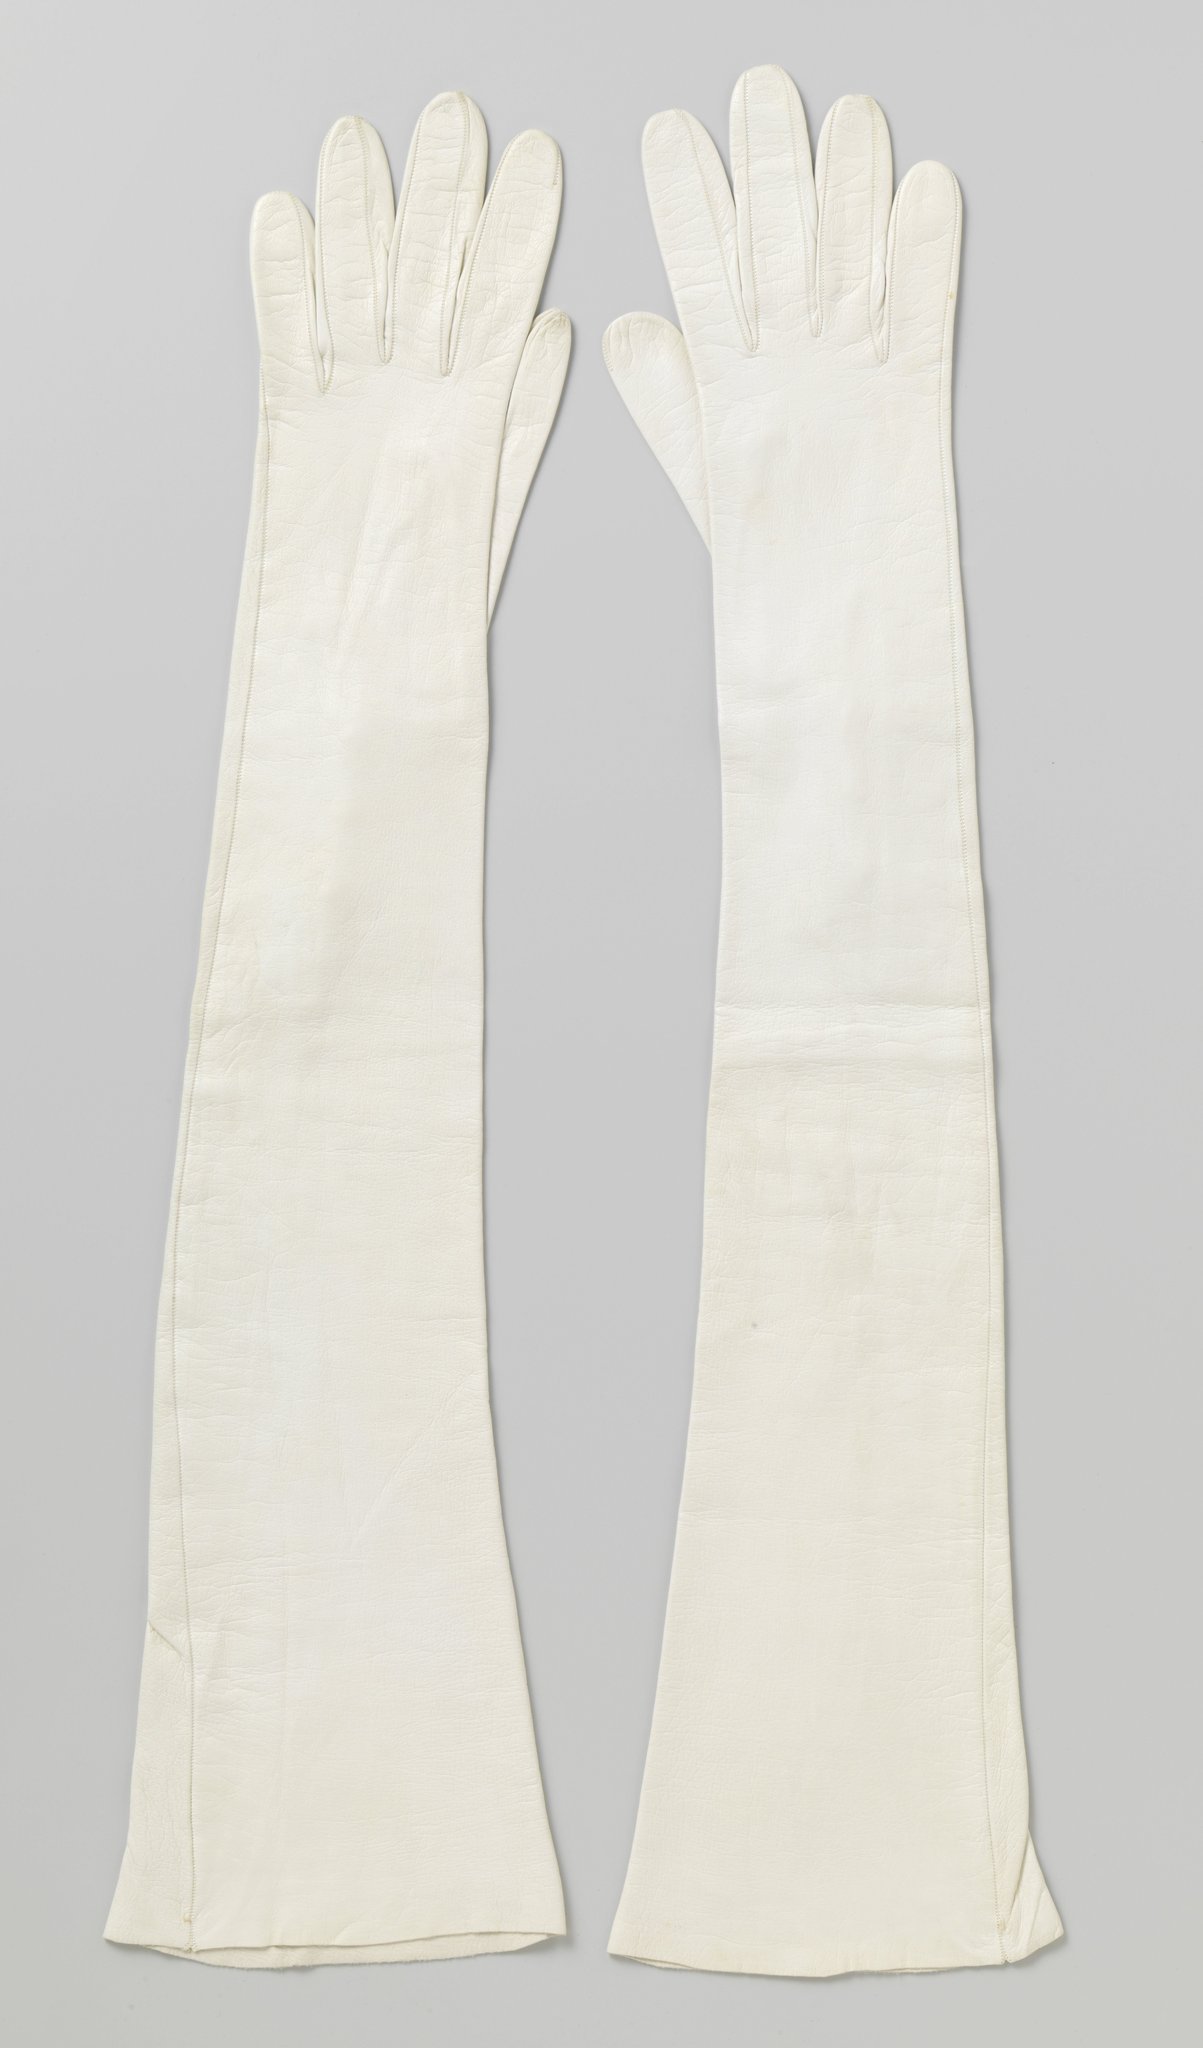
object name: glove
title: Handschoen van wit glacéleer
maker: Anonymous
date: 1900-1915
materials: plastic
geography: france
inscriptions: stamp: ‘tekst’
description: Rechterhandschoen van wit glacéleer. Bij de pols een split met drie parelmoerkleurige knopen.